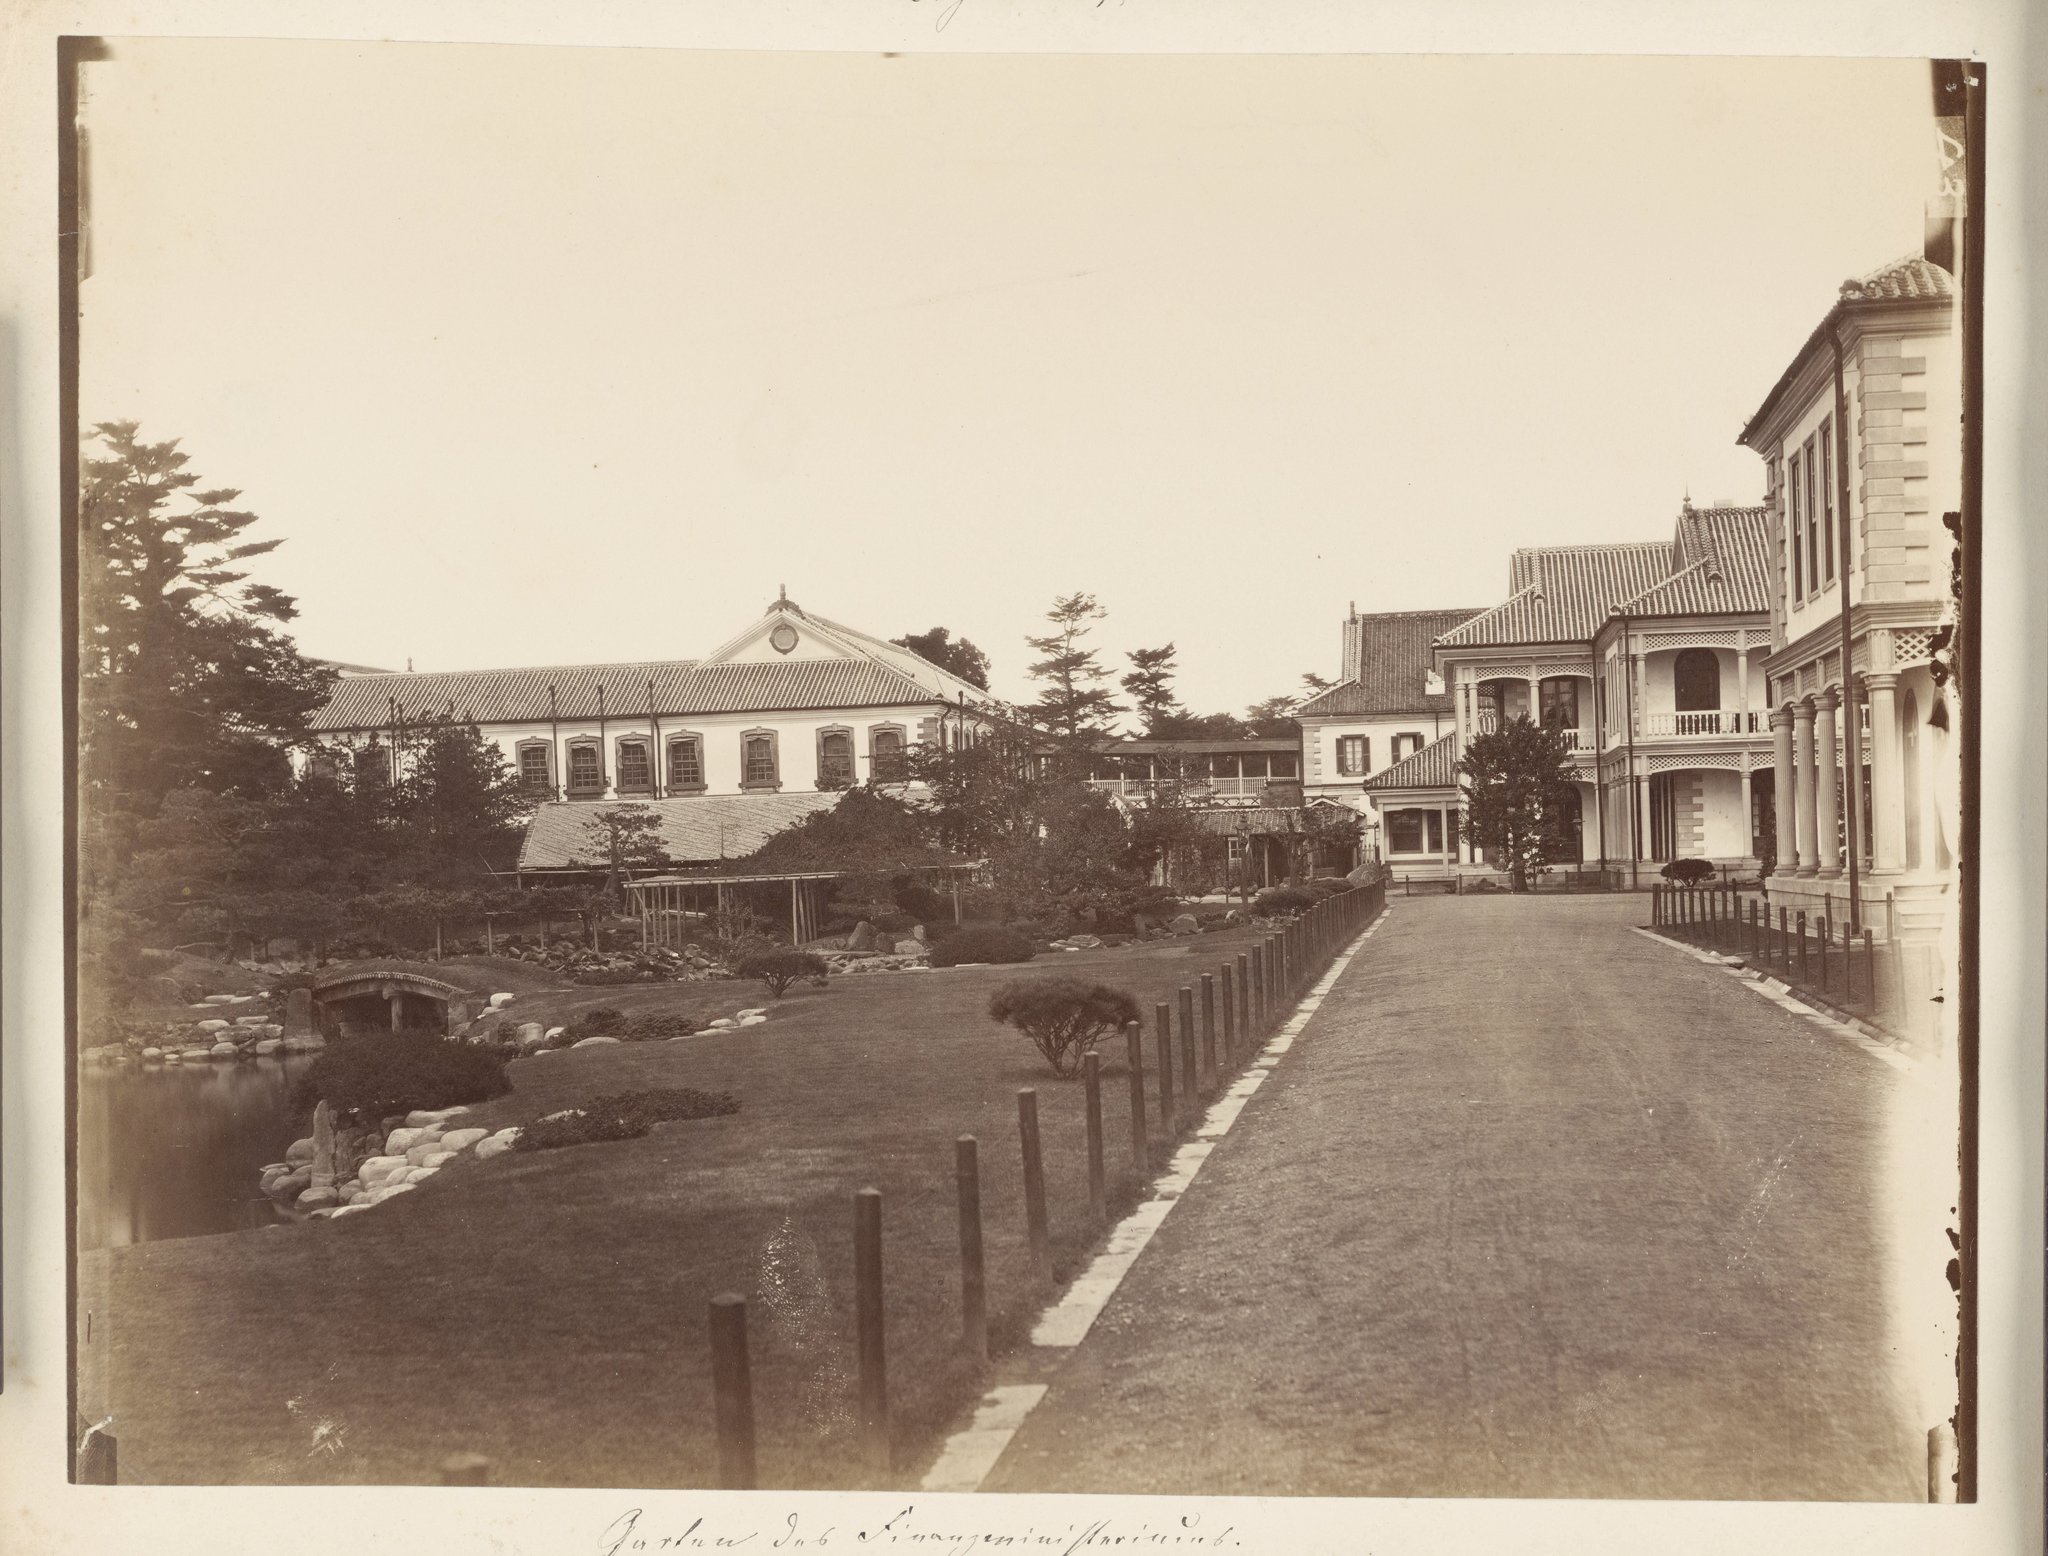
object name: photograph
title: Garlan [...]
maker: Anonymous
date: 1884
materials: cardboard, paper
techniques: albumen print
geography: japan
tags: garden, street, japan